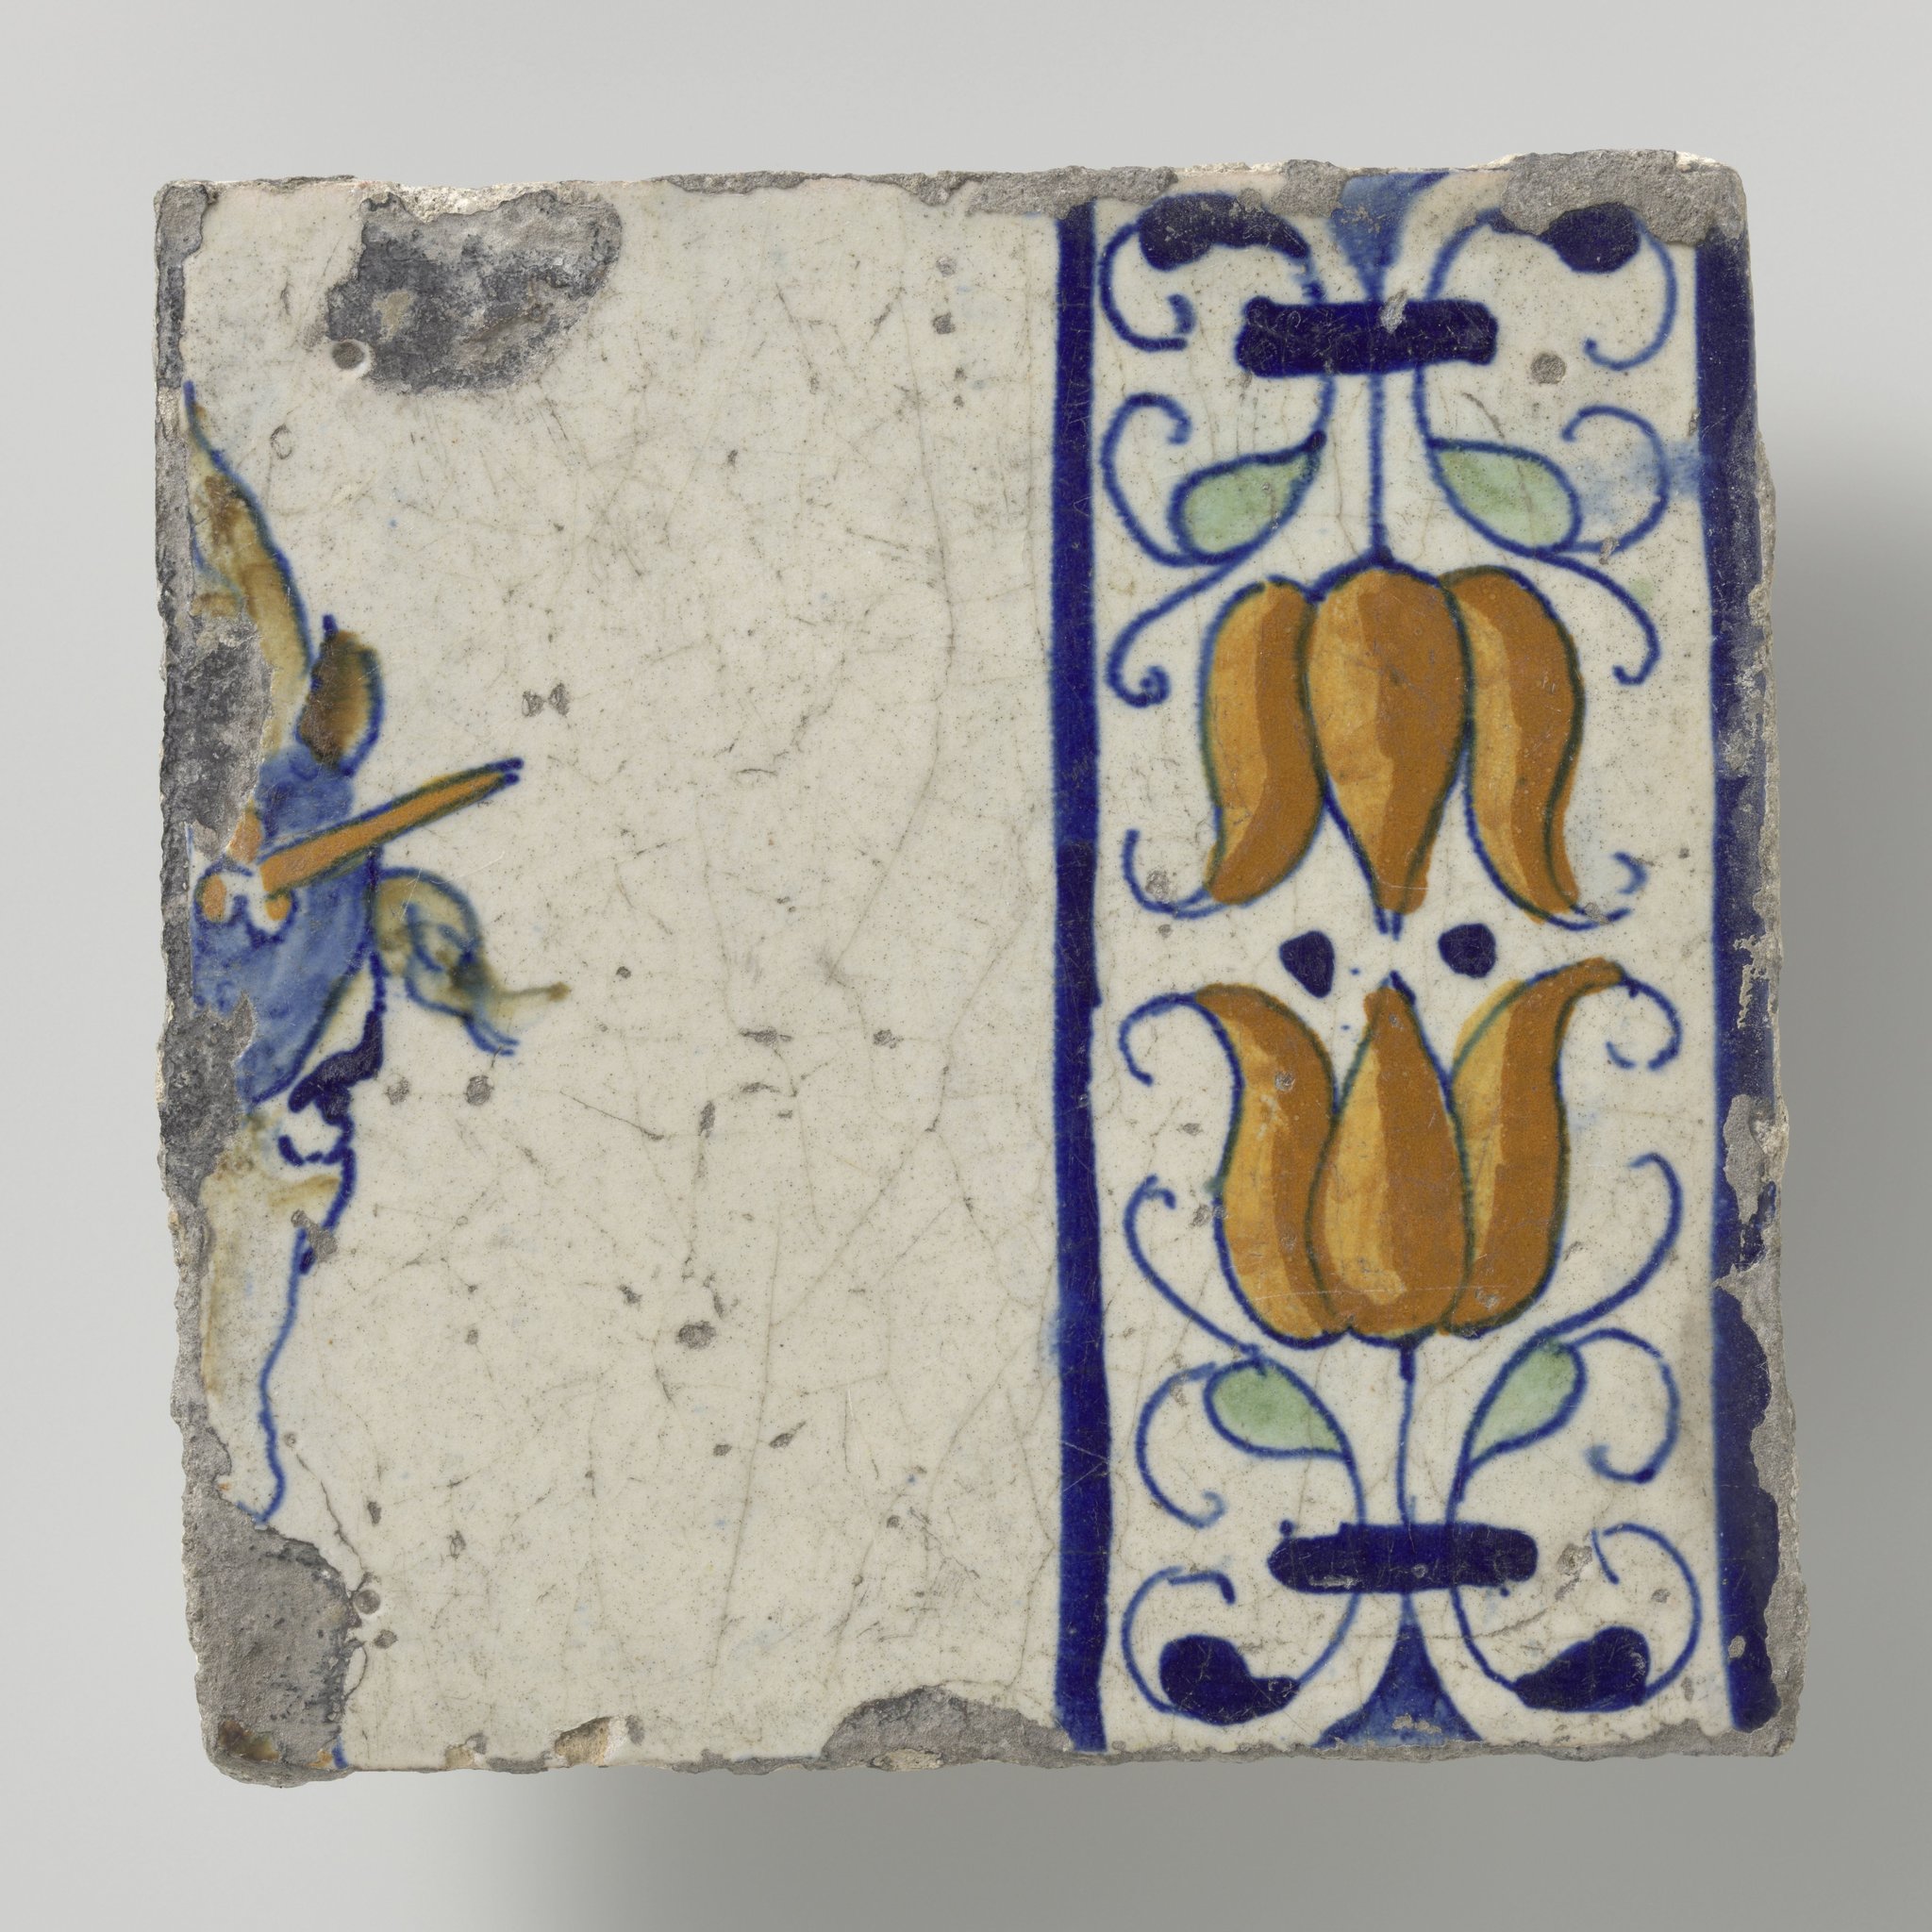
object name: tile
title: Tegeltableau met prins Maurits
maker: Anonymous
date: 1600-1625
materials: earthenware, glaze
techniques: maiolica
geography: netherlands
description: Losse tegel behorende tot het tegeltableau met Prins Maurits.